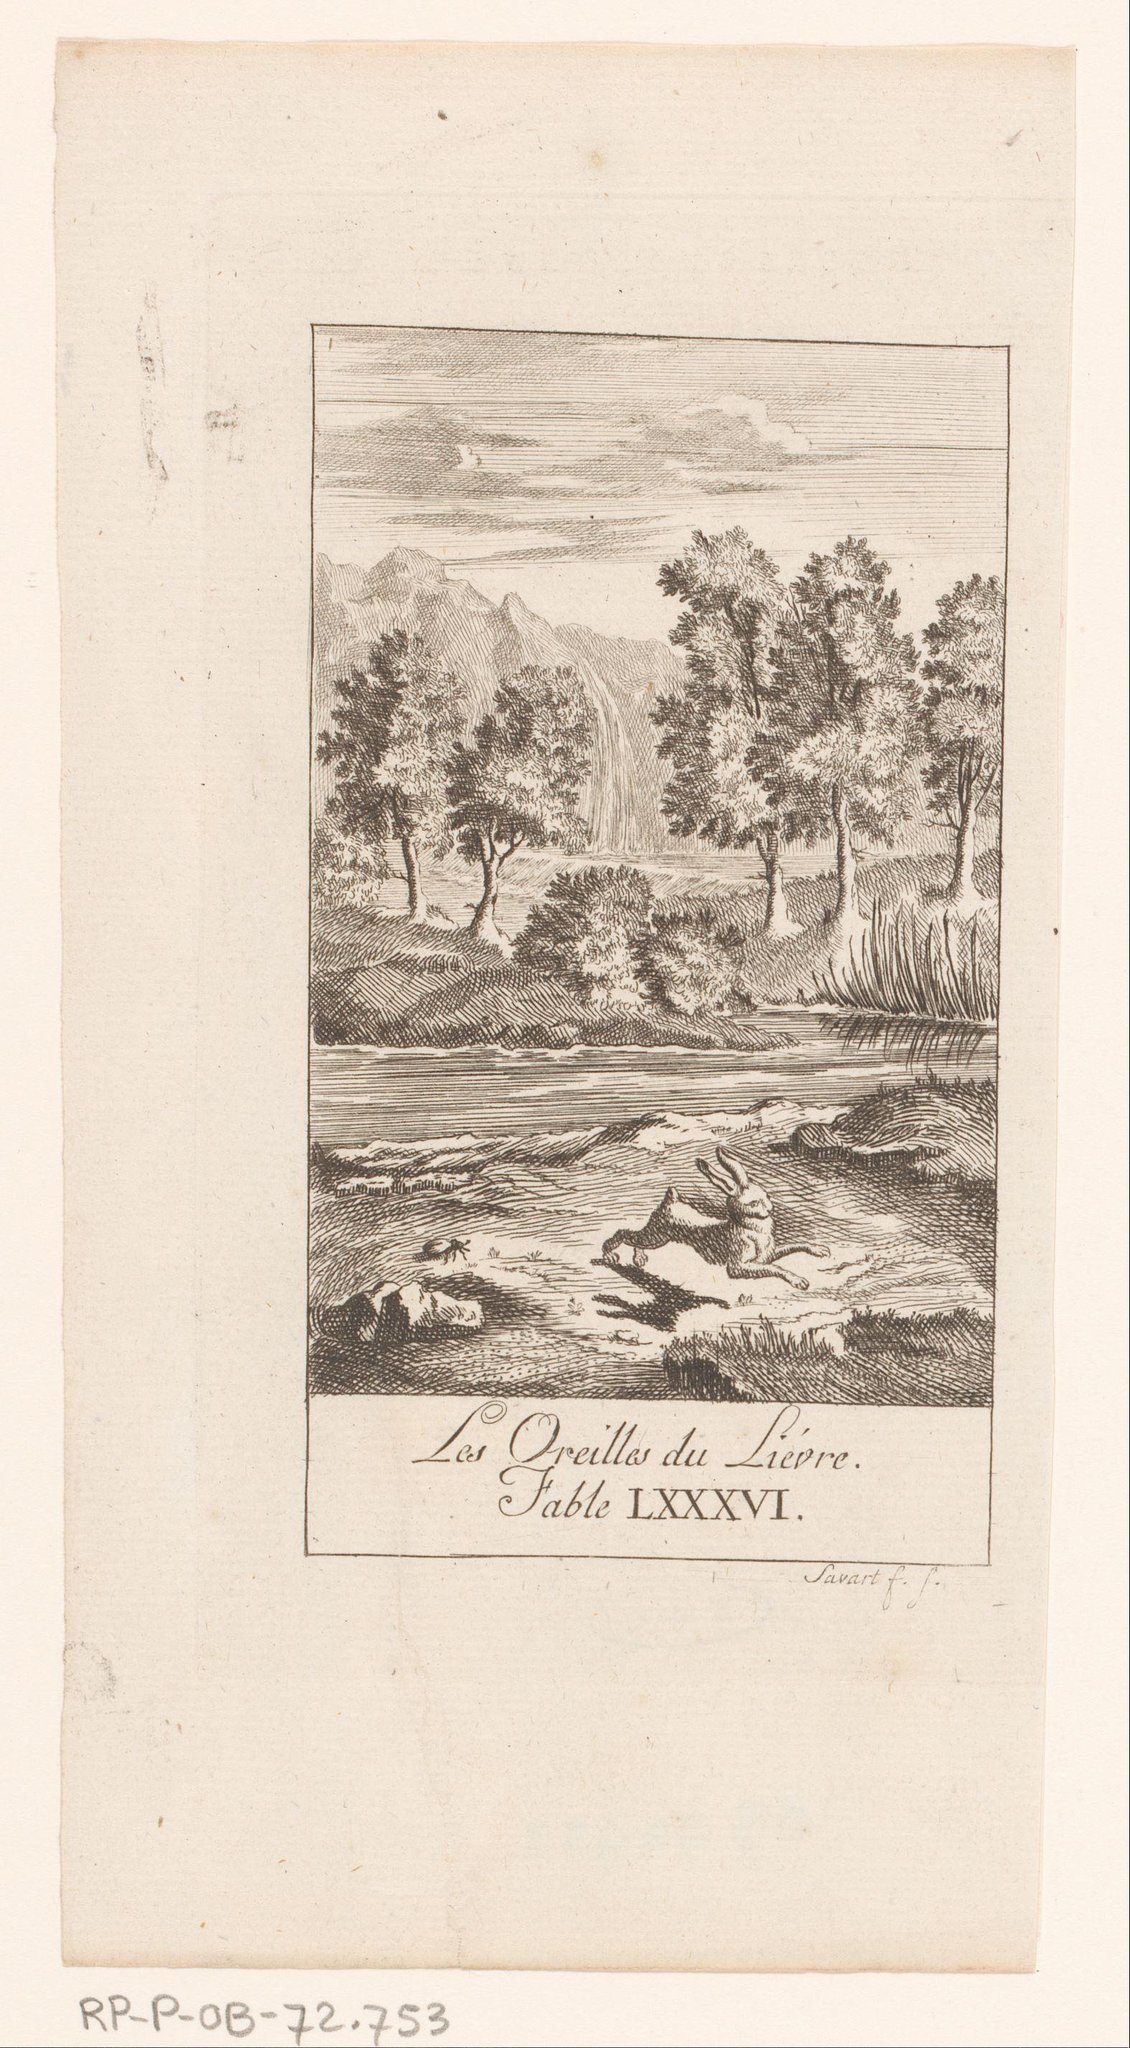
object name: book illustration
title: Les Oreilles du Liévre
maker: pierre savart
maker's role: painter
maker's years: 1737-1780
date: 1747-1847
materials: paper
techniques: etching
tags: landscapes, rodents: hare, fables, insects: beetle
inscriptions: collector's mark: Lugt 2228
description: Prent uit: La Fontaine, Jean de. Fables choisies, mises on vers. Bouillon: La Société Typographique, 1776, fabel LXXXVI.